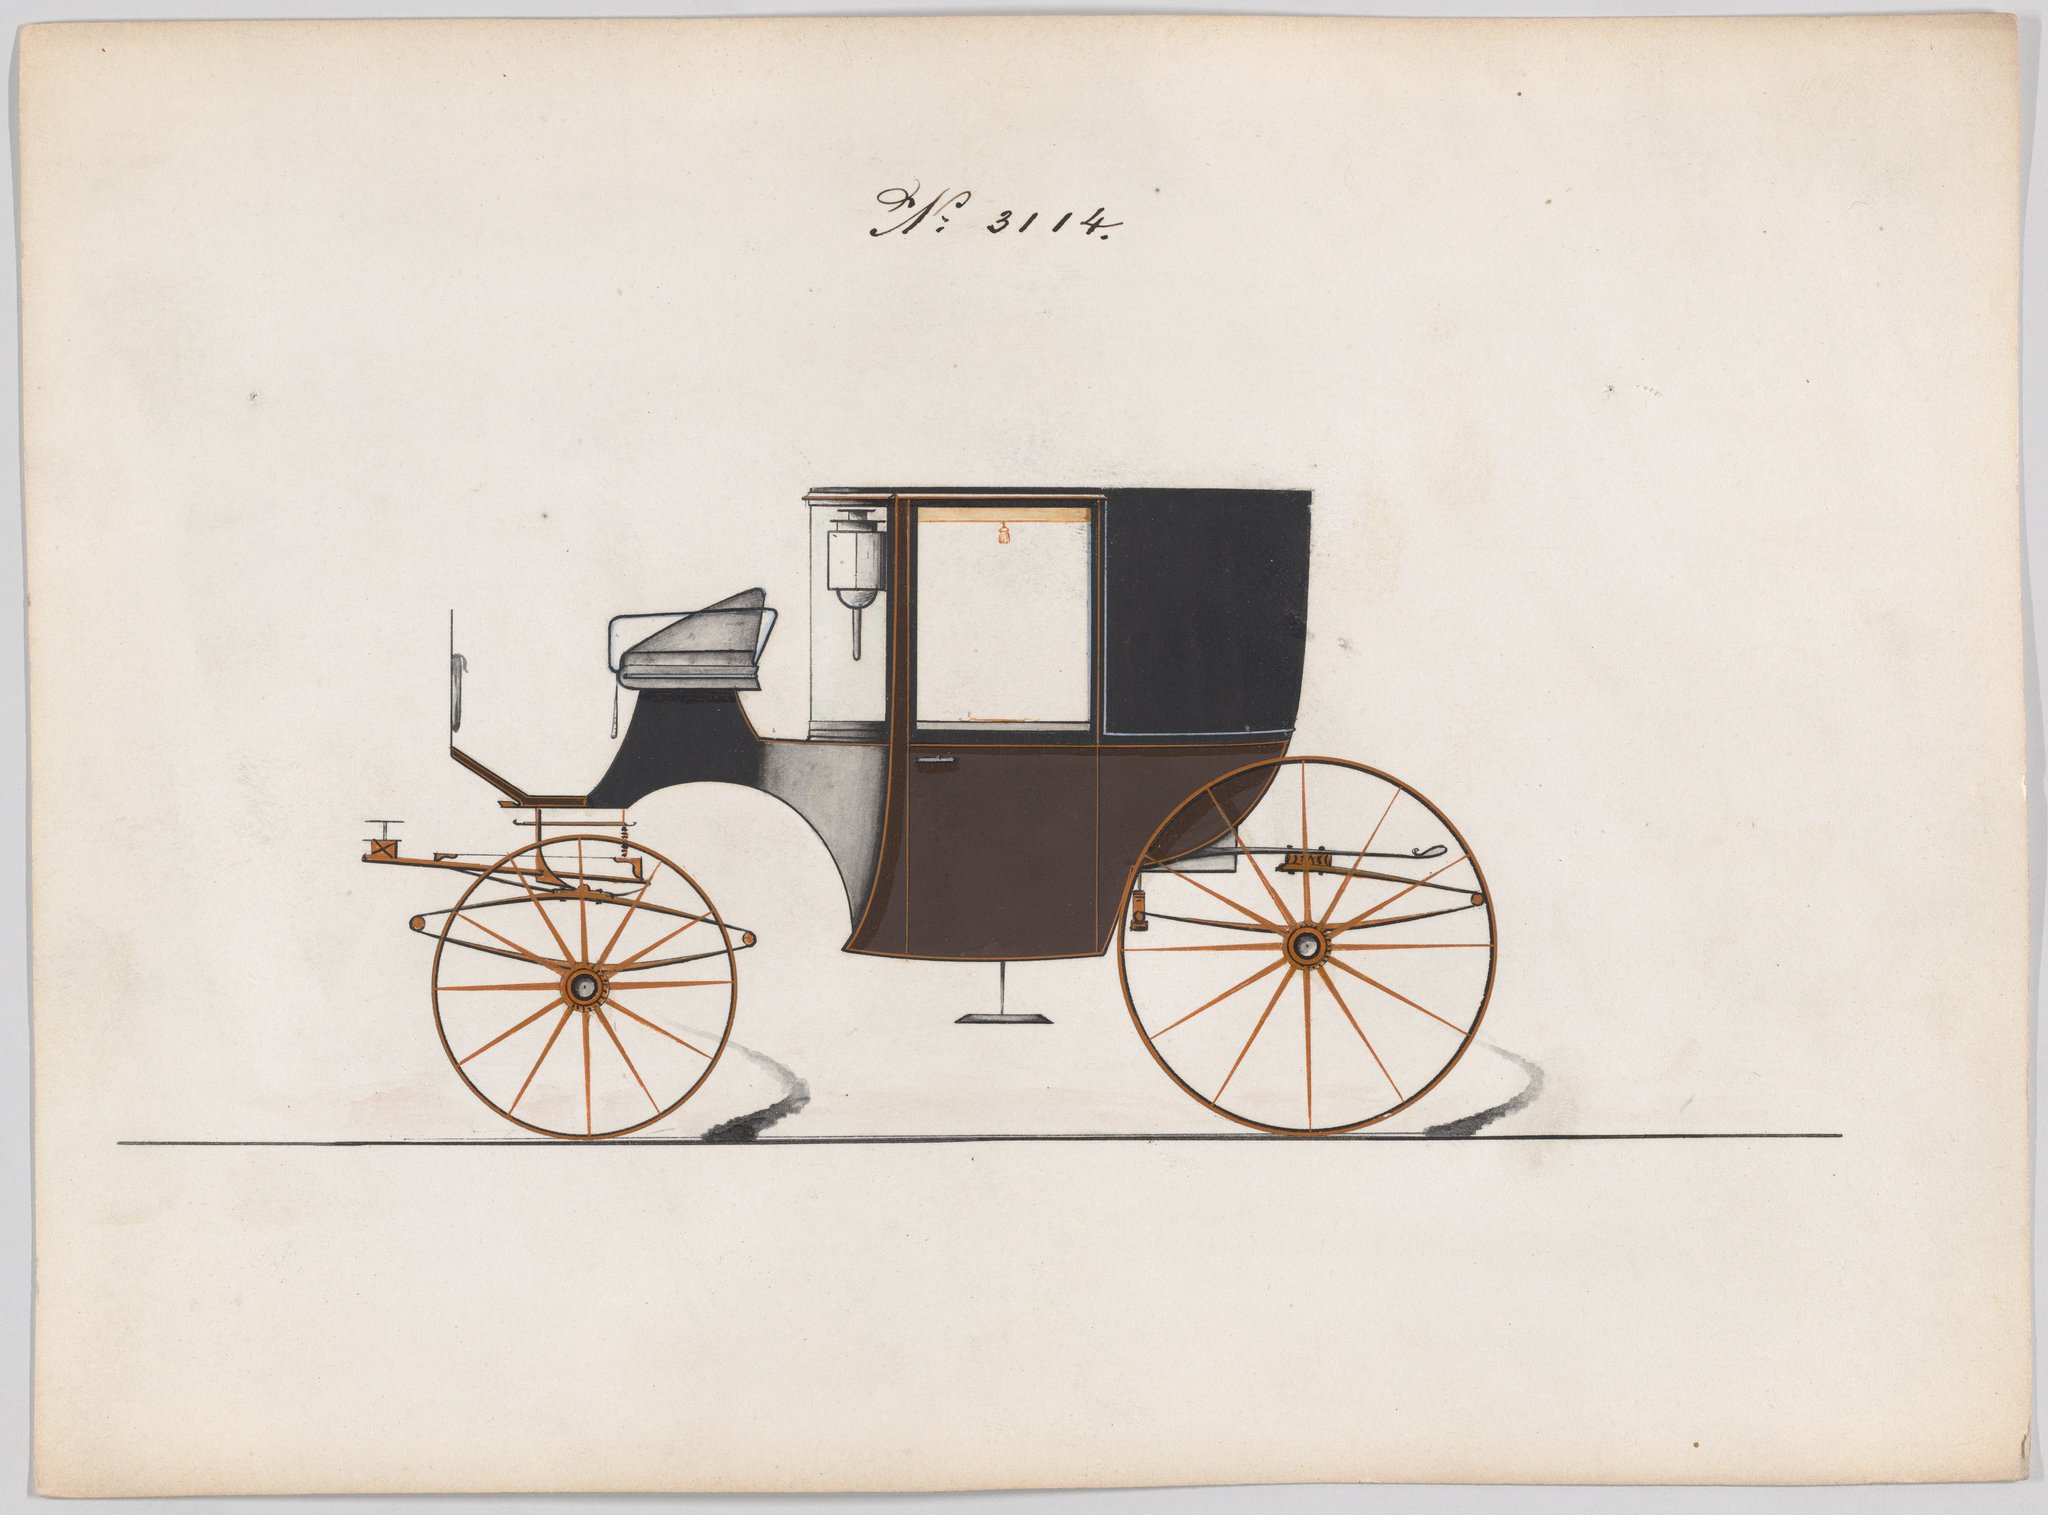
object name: drawing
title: Design for Coupé, no. 3114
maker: brewster & co.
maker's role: manufacturer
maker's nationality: american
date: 1875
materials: gouache, gum arabic, ink, watercolor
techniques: pen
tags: carriages